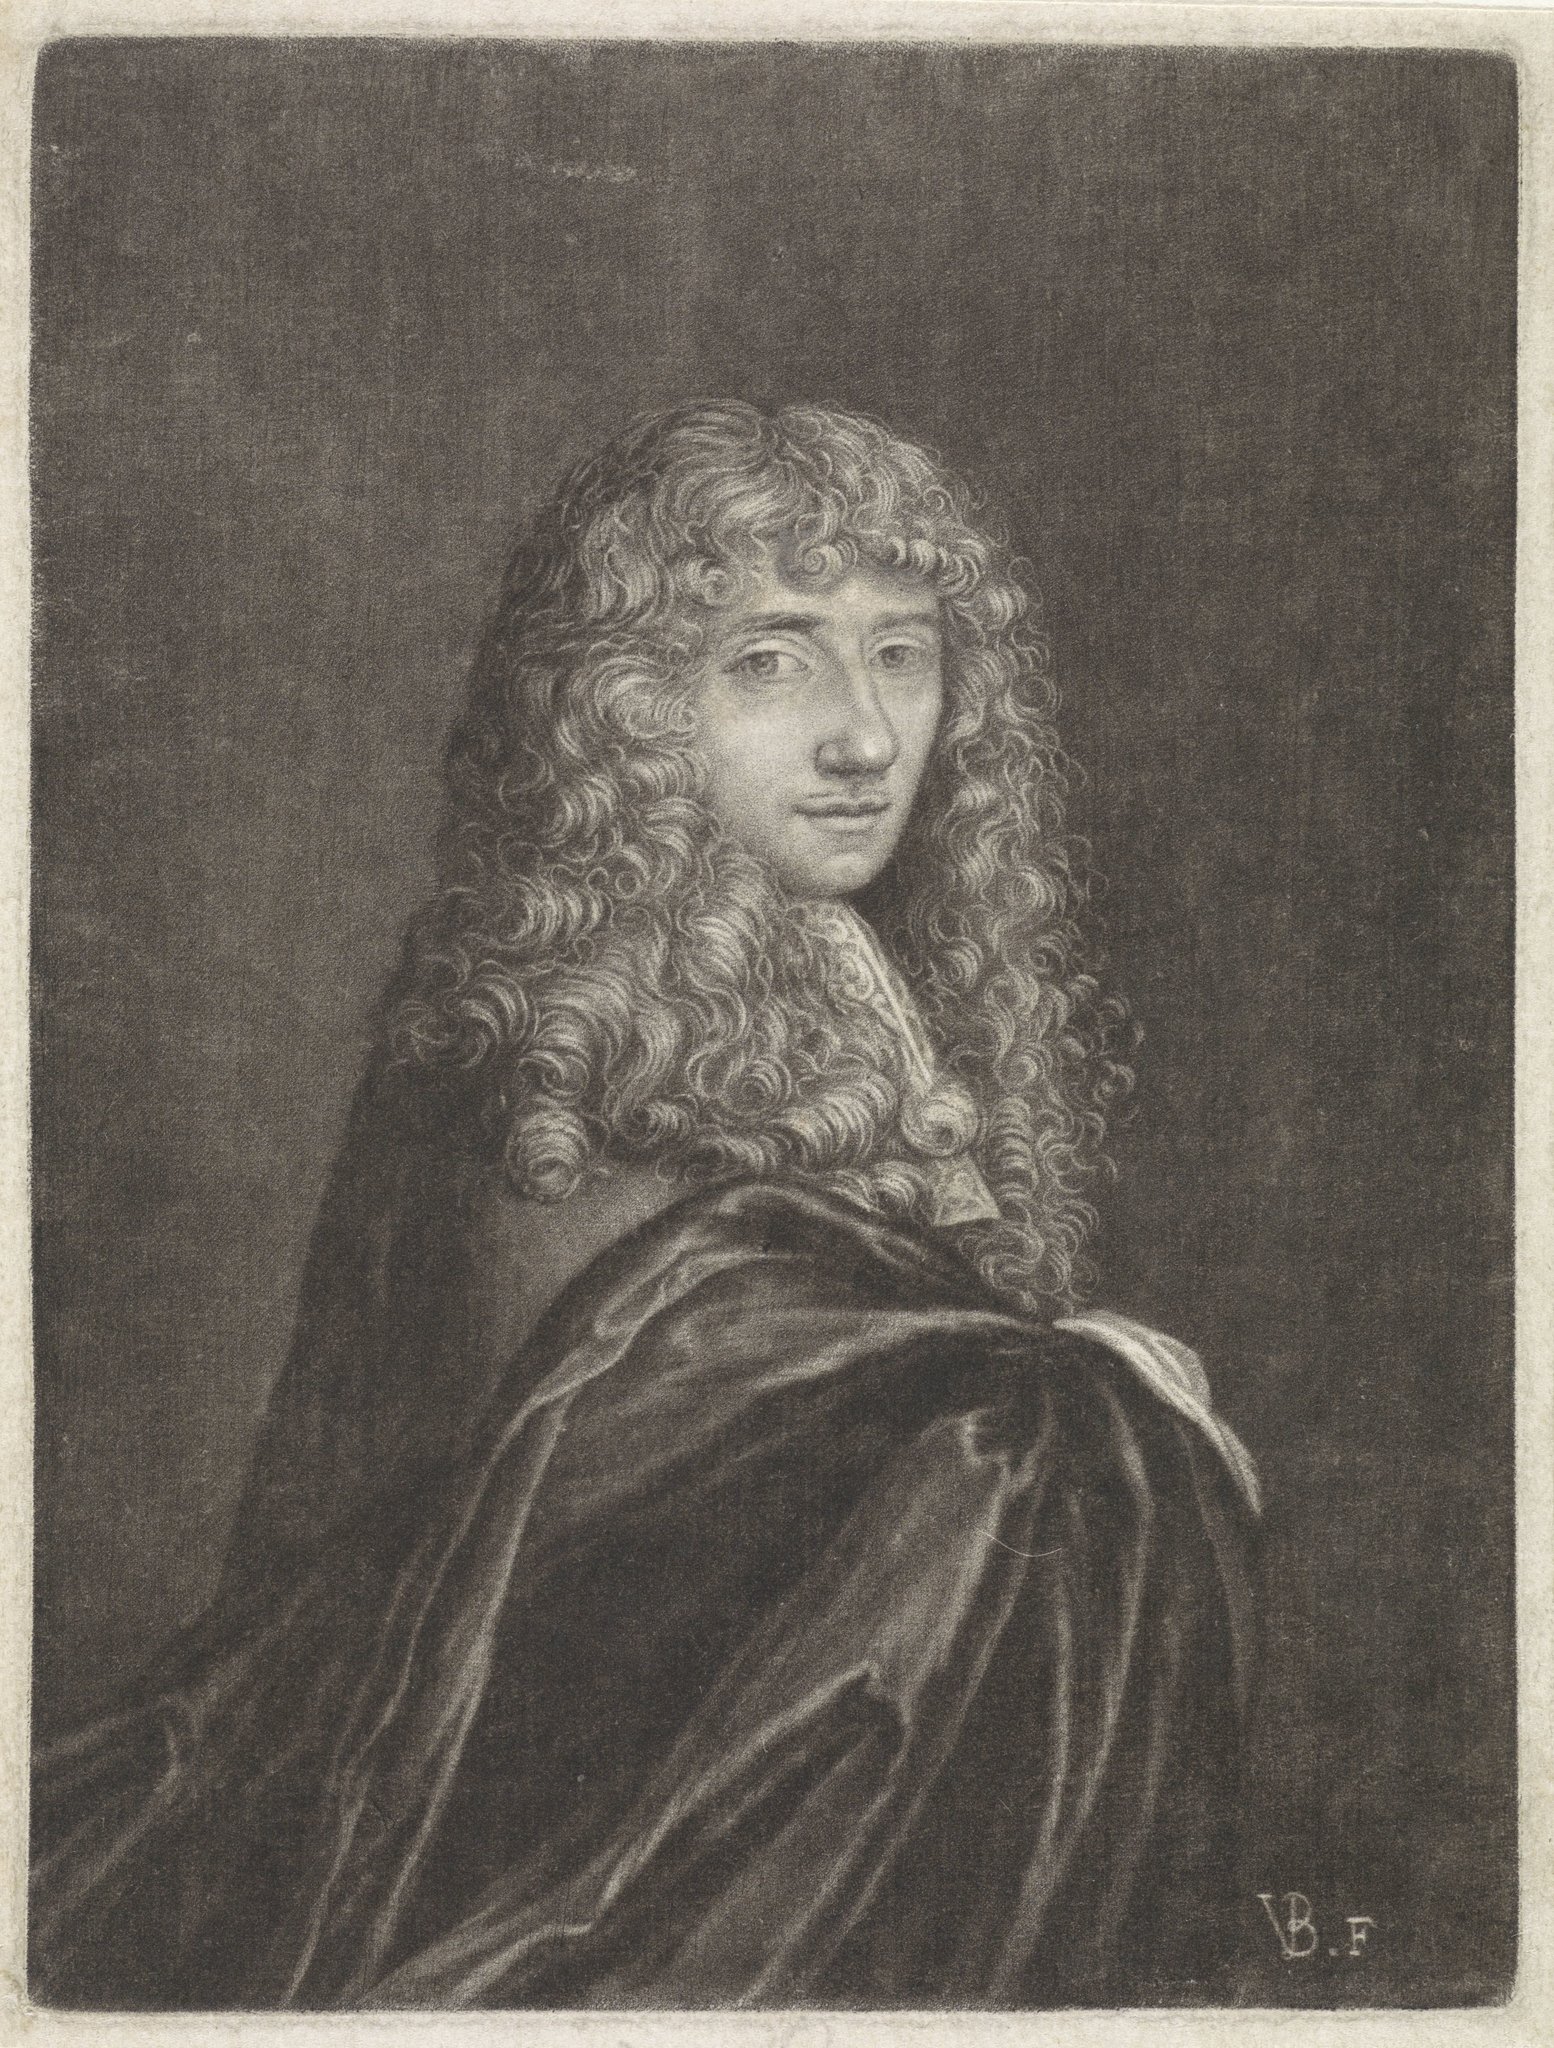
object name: print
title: Portret van Antoine Masson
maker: jan van der bruggen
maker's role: draughtsman, print maker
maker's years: 1649-1709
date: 1659-1740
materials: paper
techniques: mezzotint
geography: paris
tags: paris, print maker, antoine masson, wig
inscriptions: collector's mark: Lugt 2228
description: Portret van de Franse graveur Antoine Masson met een lange krulpruik.